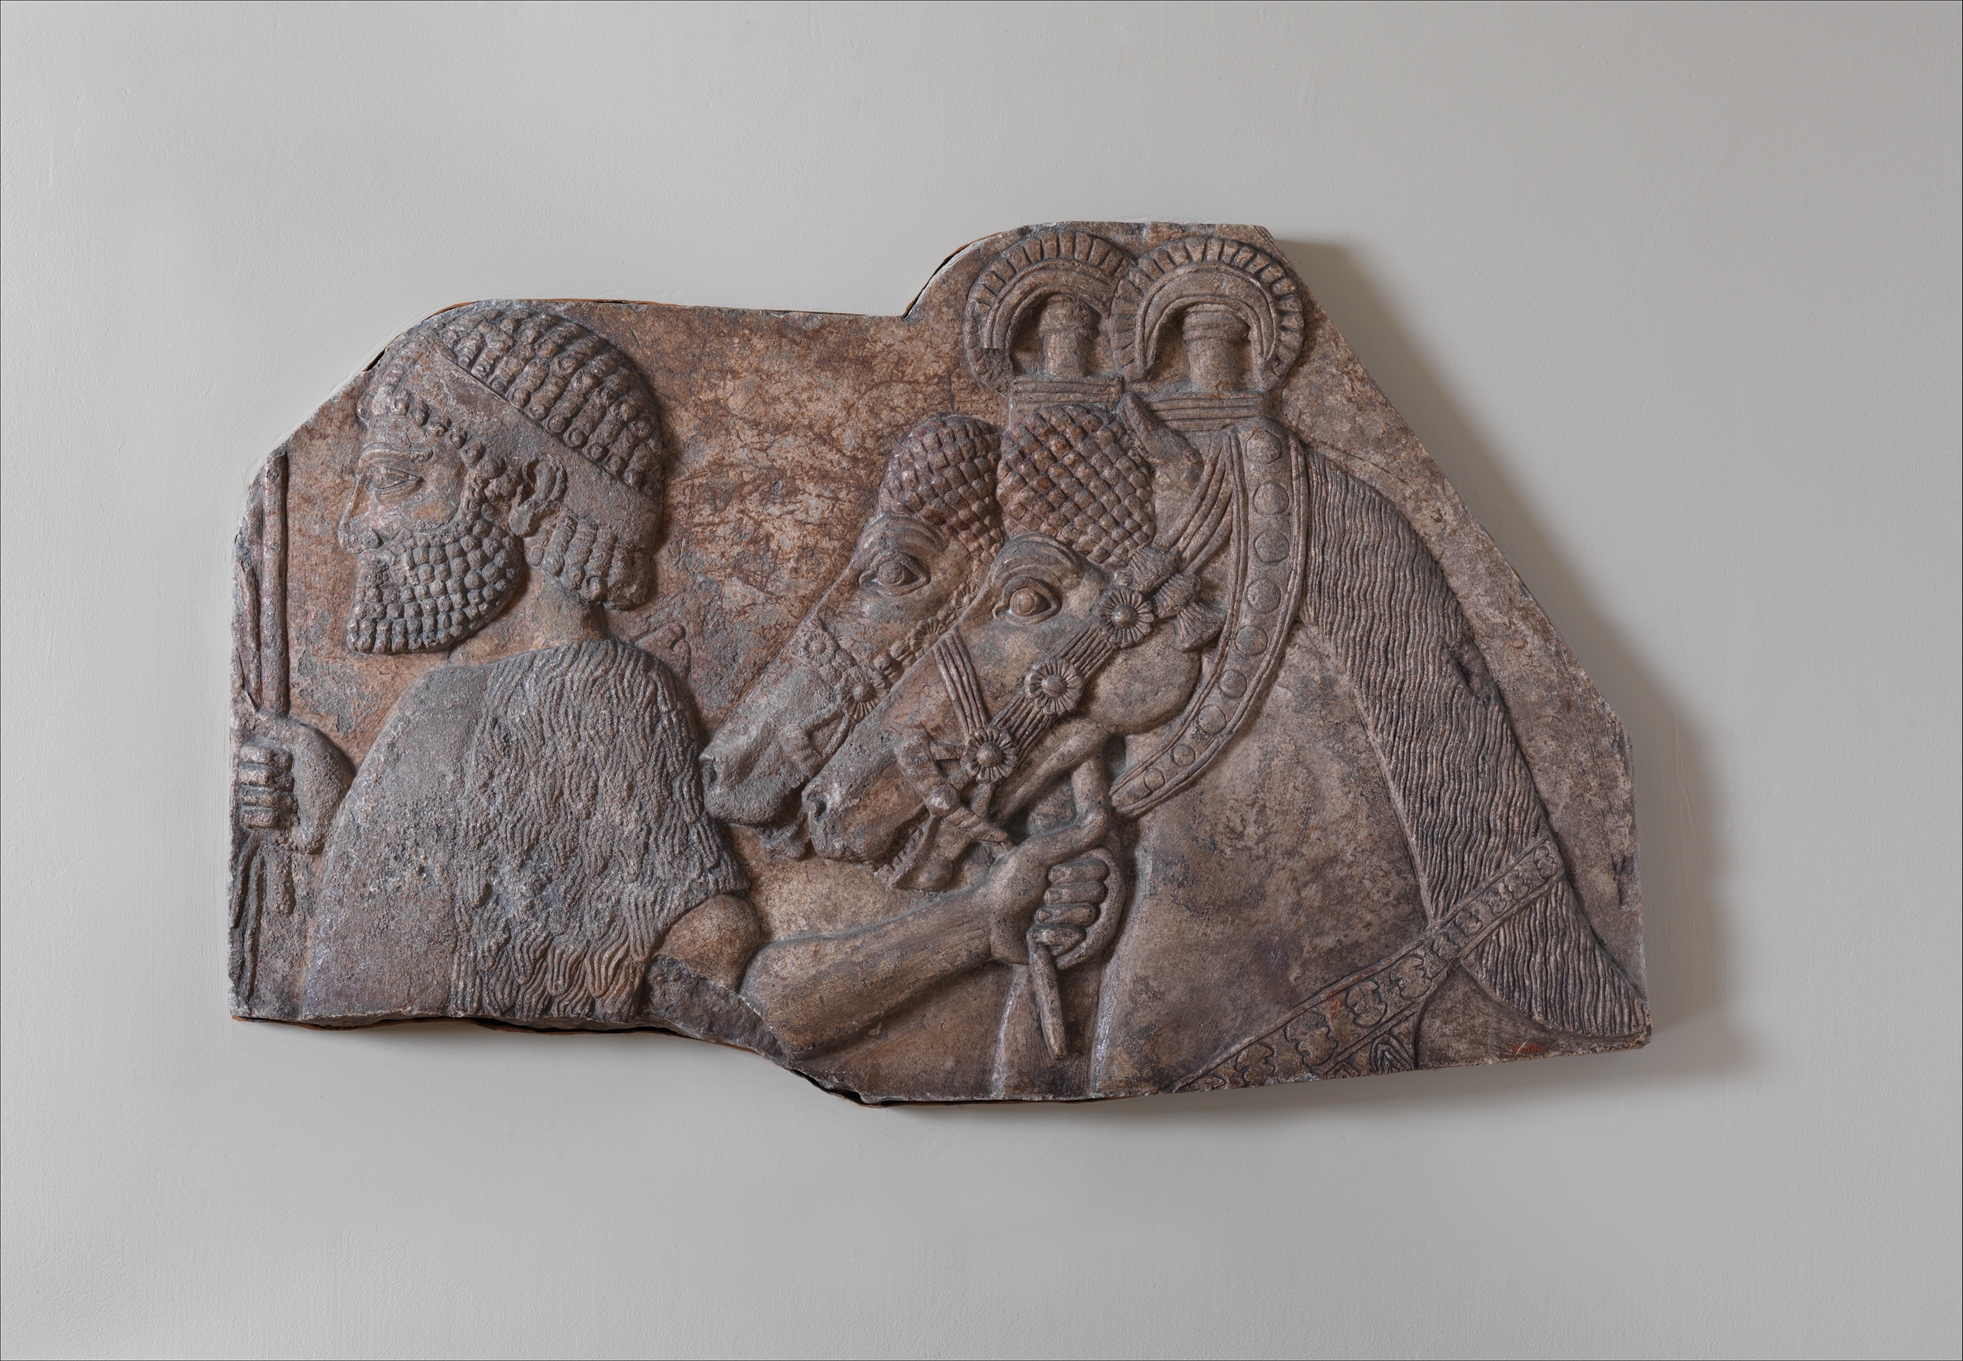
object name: relief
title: Foreign groom in a tributary procession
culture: assyrian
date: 721-705 BCE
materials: alabaster, gypsum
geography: mesopotamia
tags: men,horses